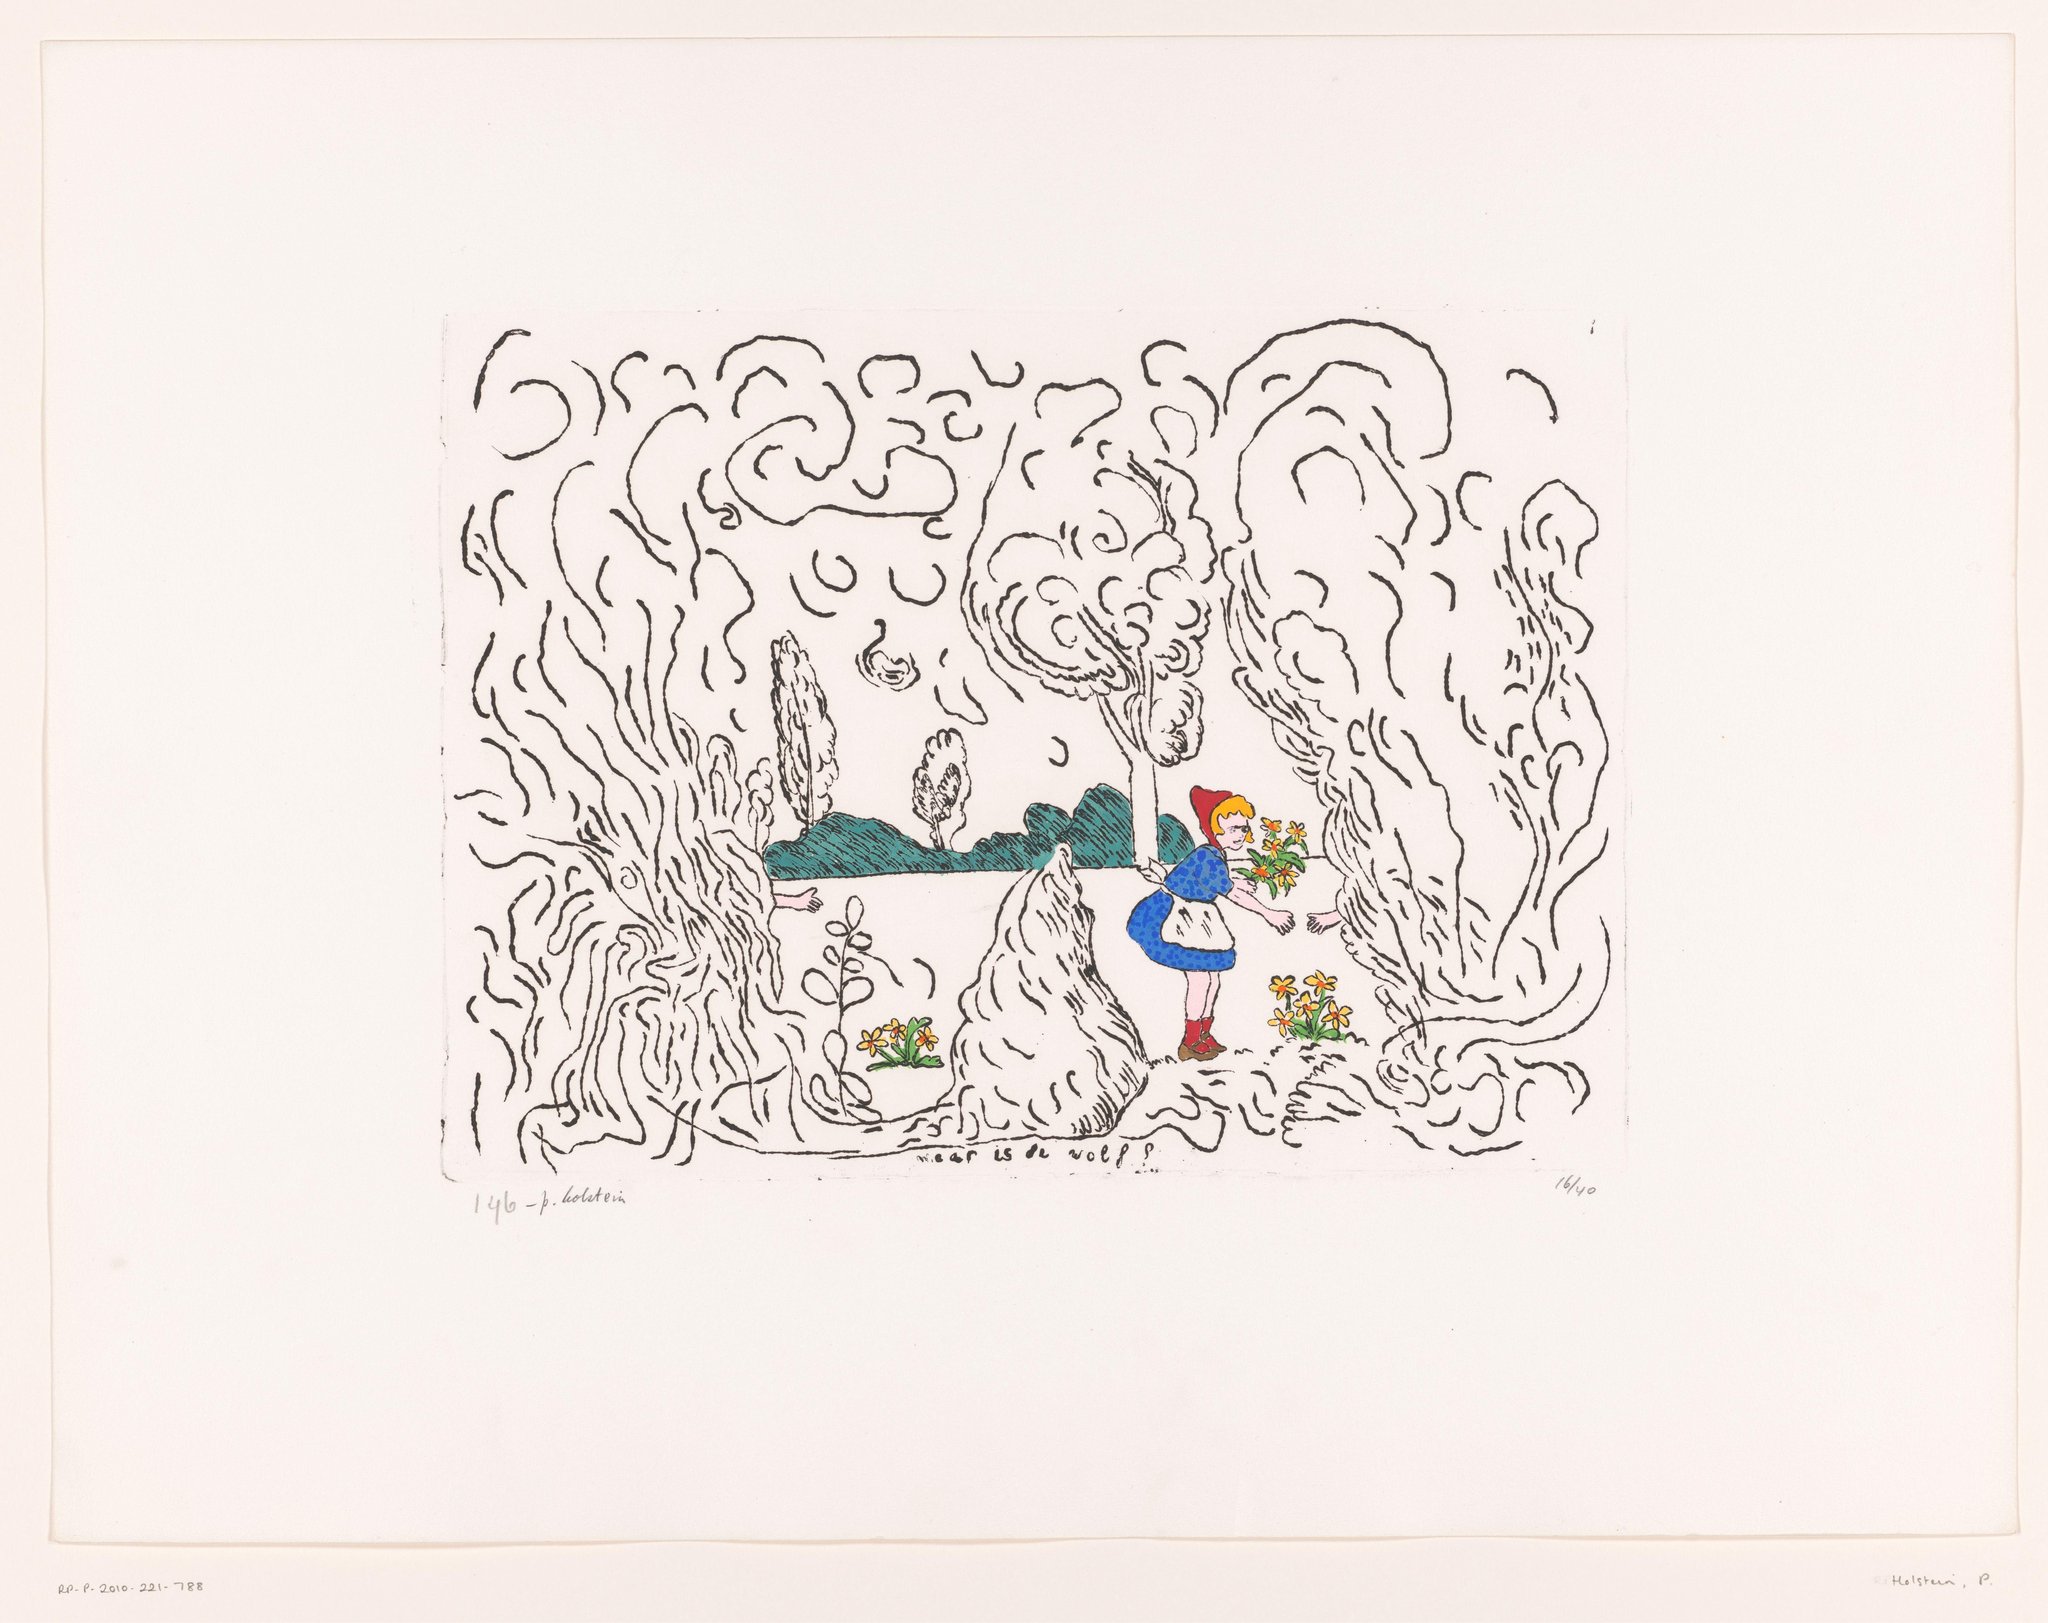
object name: print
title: Waar is de wolf?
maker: pieter holstein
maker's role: draughtsman, painter, print maker, sculptor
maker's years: 1934-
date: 1970-1975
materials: paper, watercolor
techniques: brush, etching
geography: amsterdam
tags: tales and fairy tales: little red riding-hood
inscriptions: inscription: ‘146’, signature: ‘p. holstein’, title: ‘waar is de wolf?’, edition: ‘16/40’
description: Bloemen plukkende Roodkapje in een bos. Uit de struiken reiken handen.